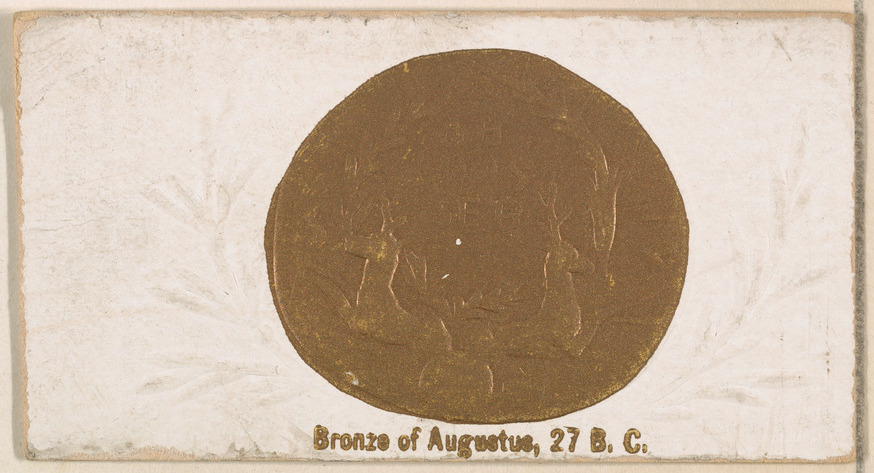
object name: print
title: Bronze of Augustus, 27 B.C., from the Ancient Coins series (N180) issued by Wm. S. Kimball & Co.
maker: william s. kimball & company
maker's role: publisher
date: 1888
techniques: color lithograph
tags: coins